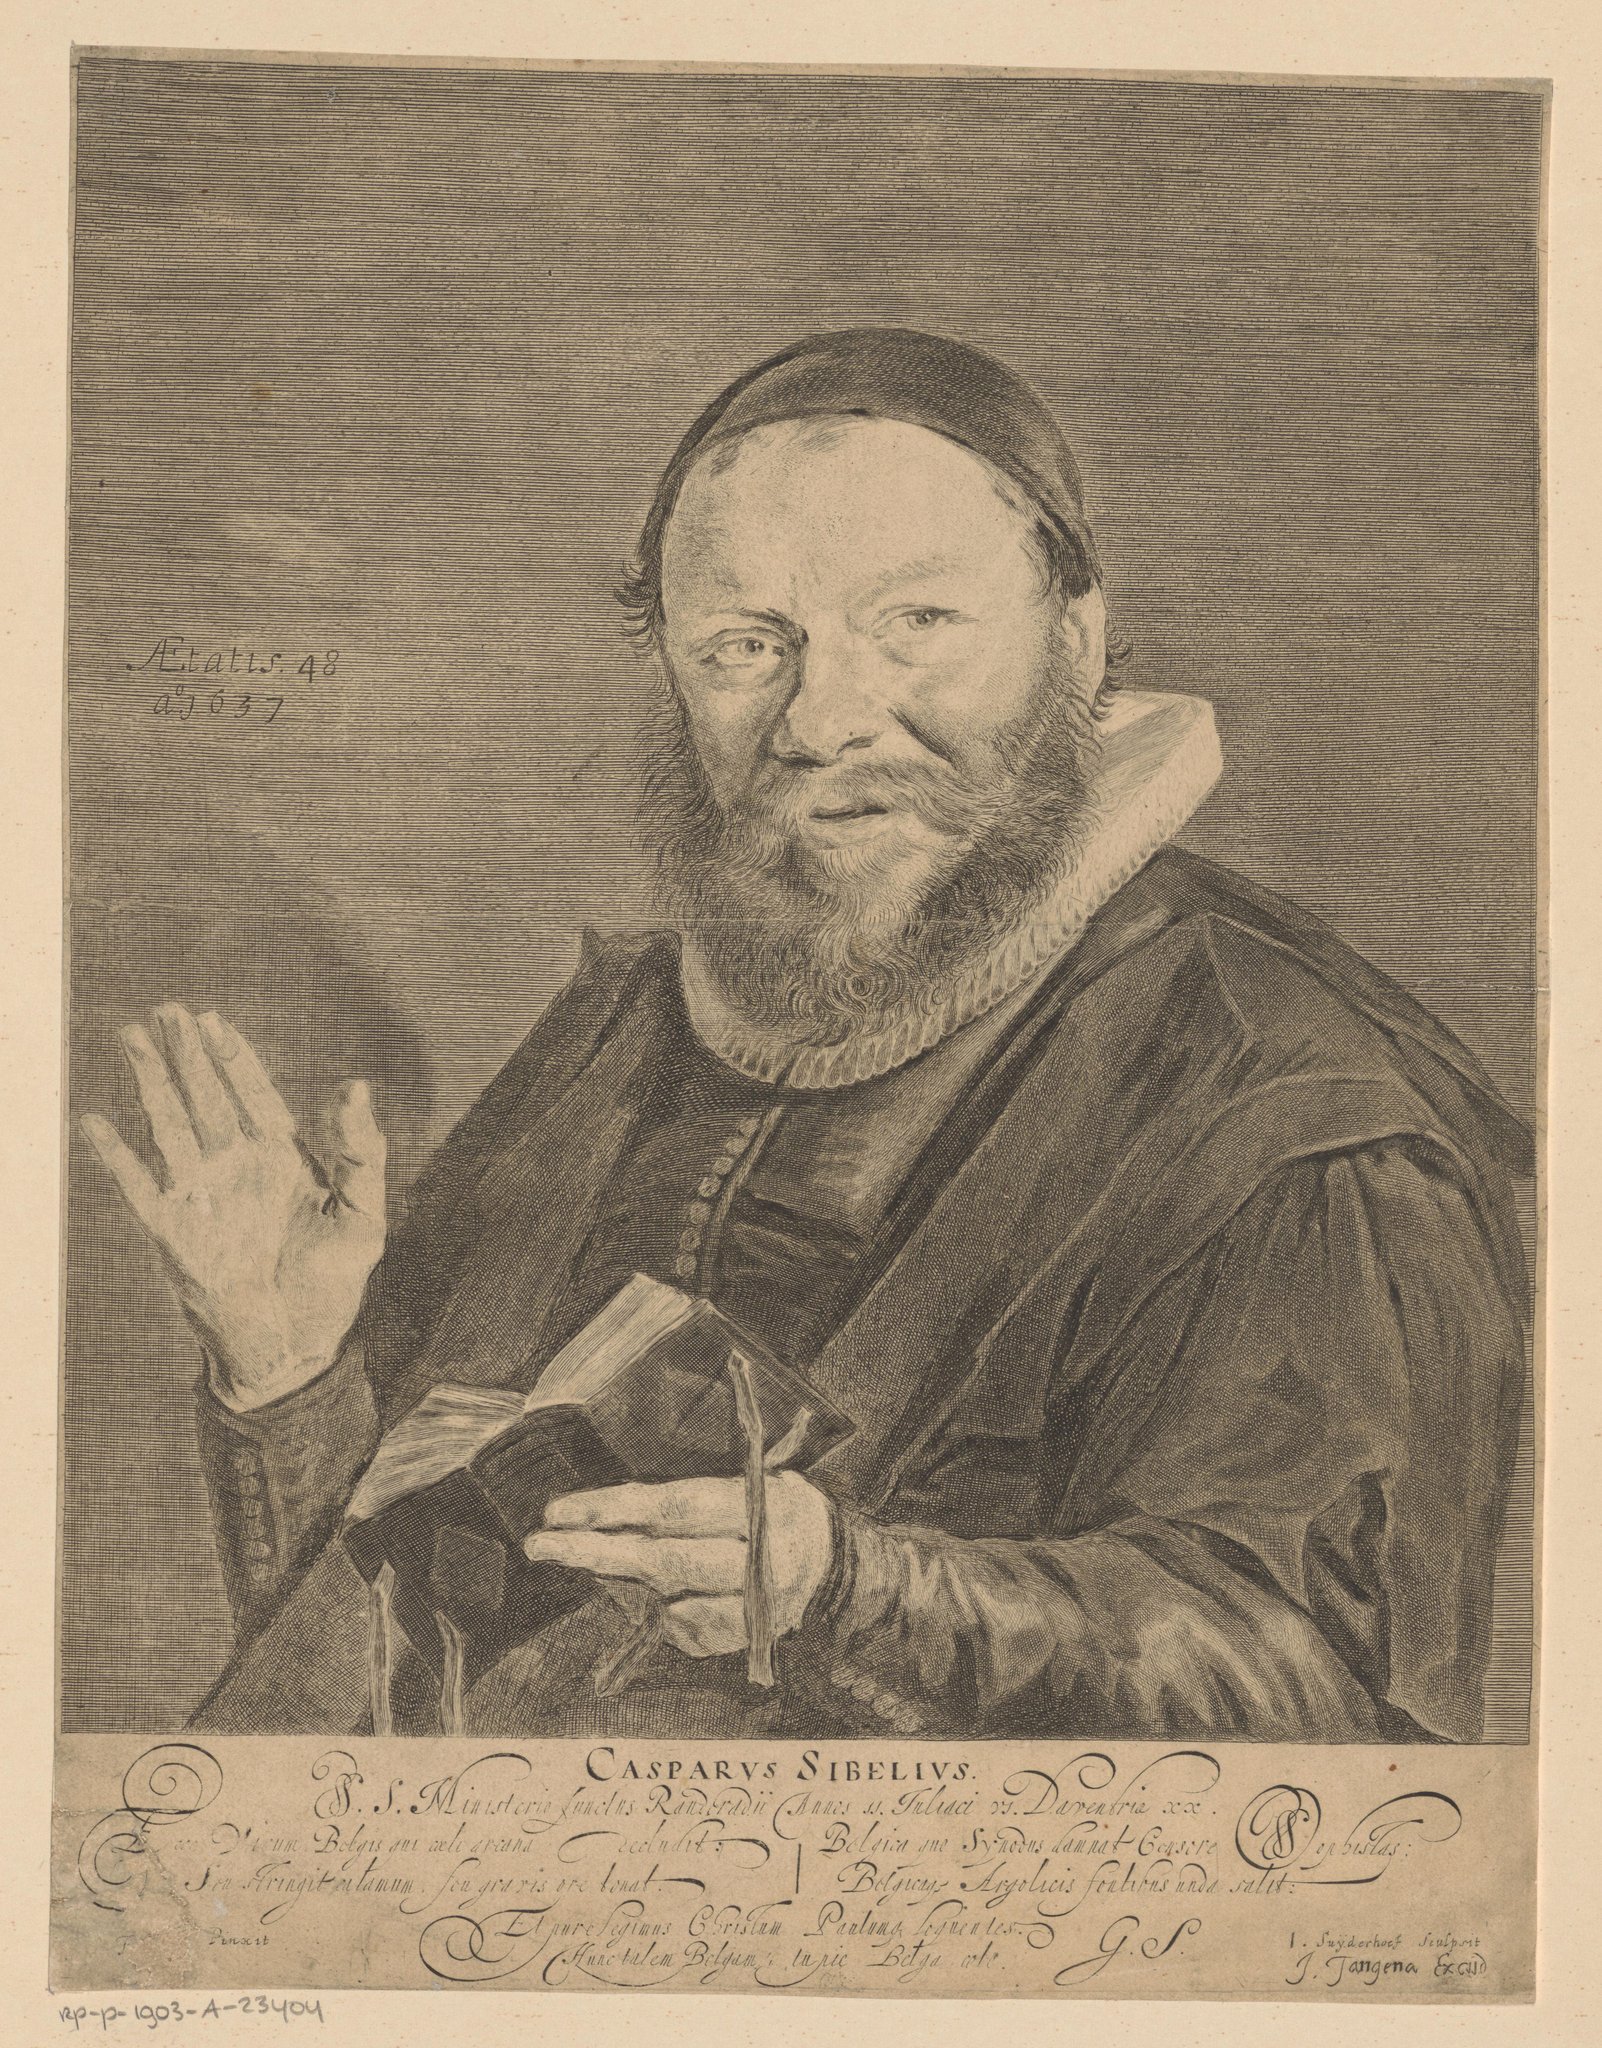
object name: print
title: Portret van Caspar Sibelius op 48-jarige leeftijd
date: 1637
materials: paper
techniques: engraving, etching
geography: haarlem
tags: deventer, theologian, historical persons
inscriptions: collector's mark: Lugt 2228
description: Met vijfregelig onderschrift in het Latijn.